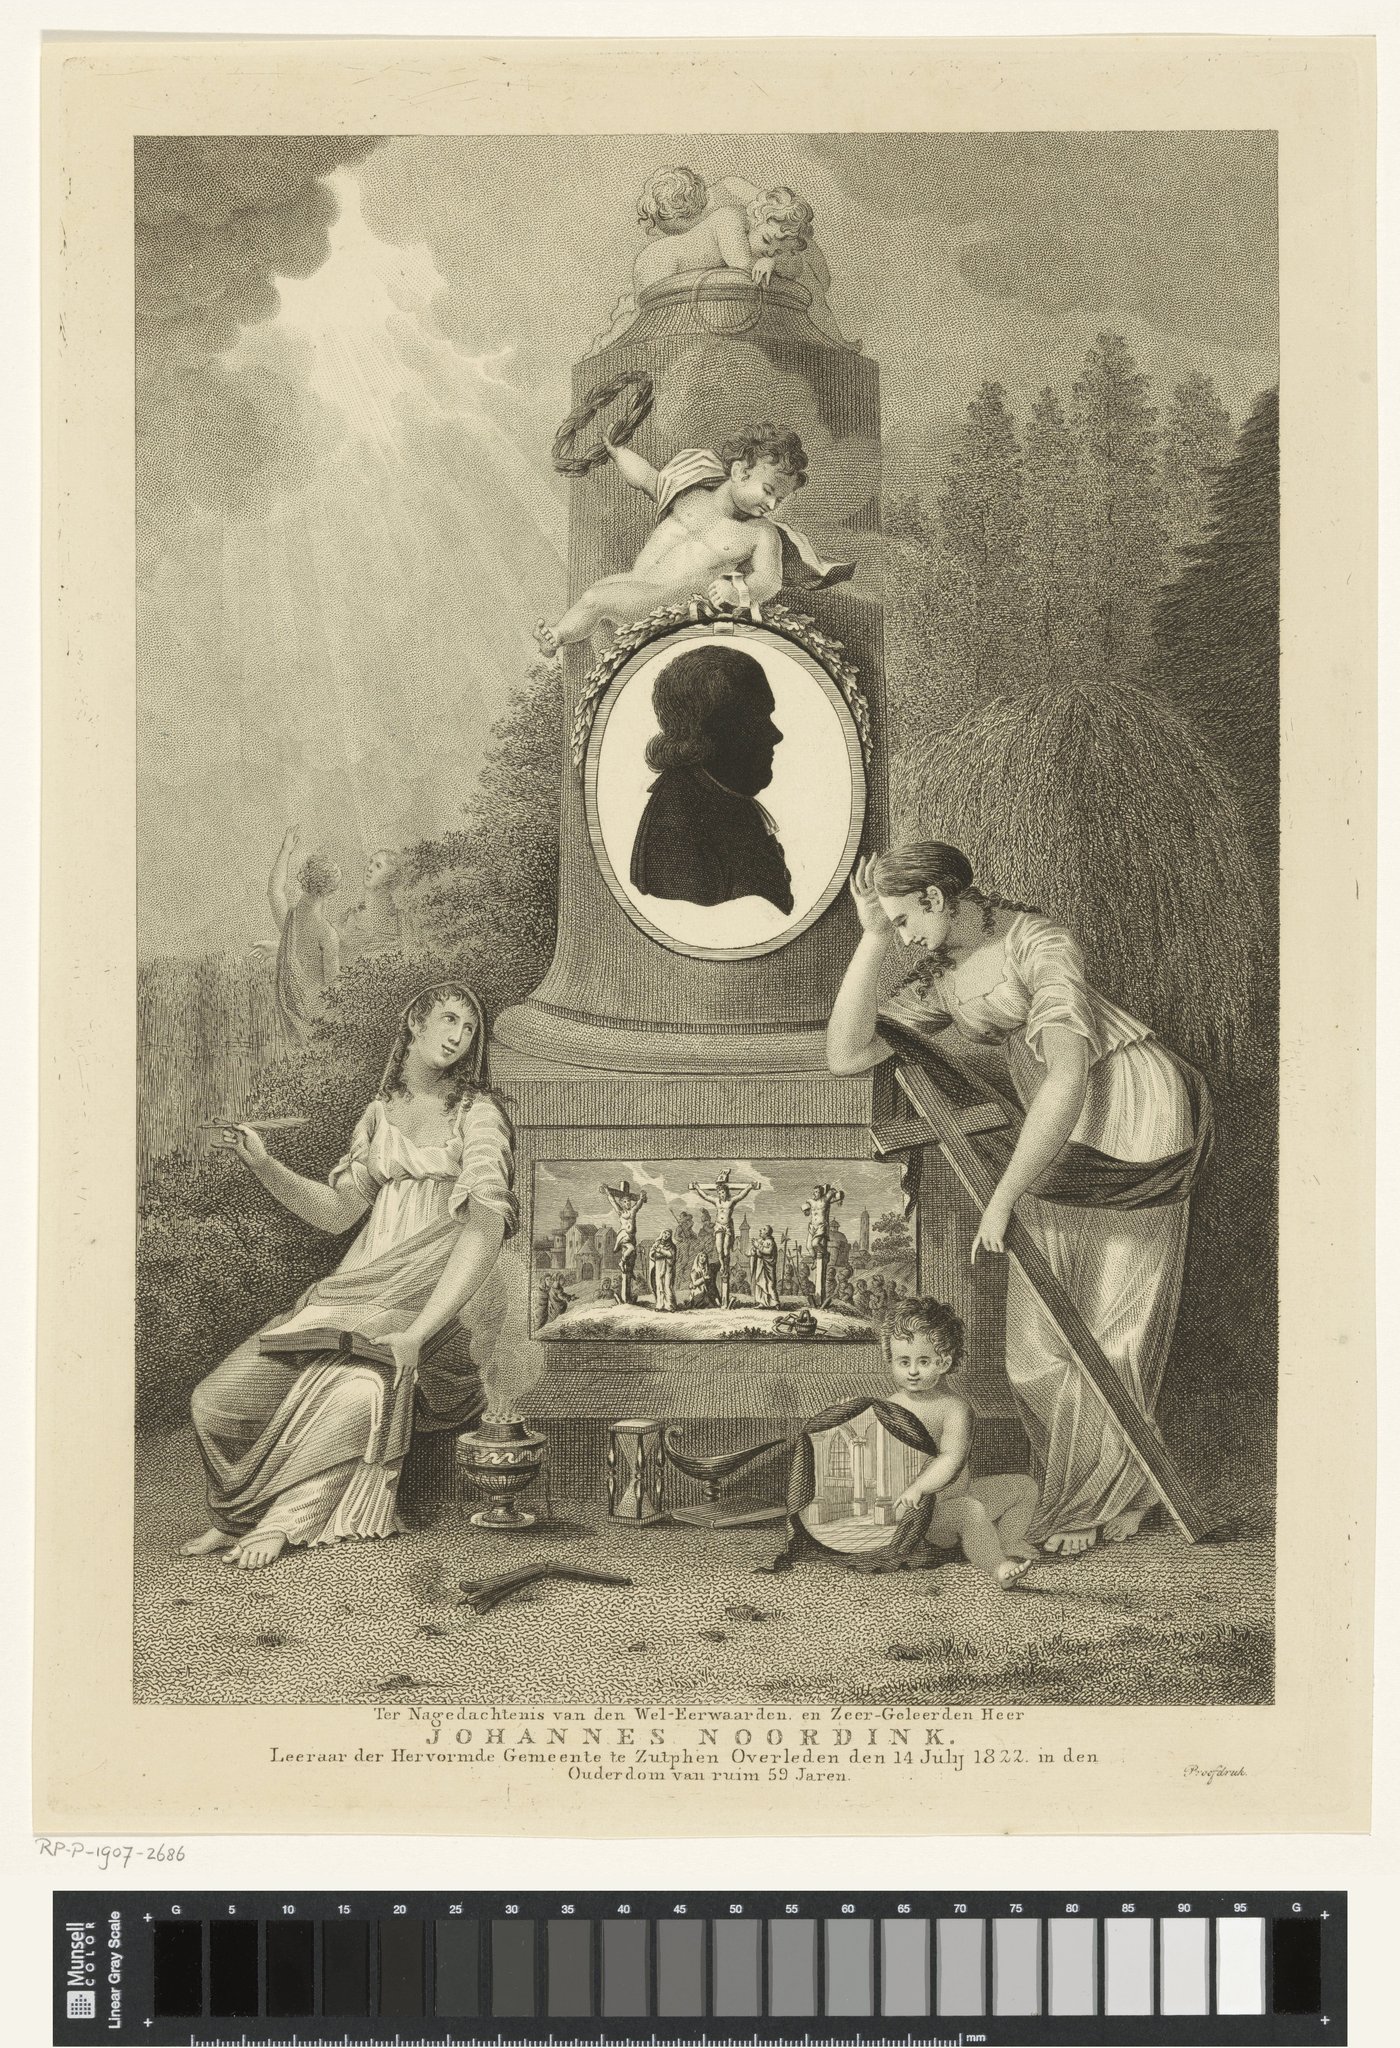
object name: print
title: Monument voor Johannes Noordink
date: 1822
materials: paper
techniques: engraving, etching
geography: amsterdam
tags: symbols of last judgement, torch (+ extinguishing; extinguished light, lamp, candle), faith, 'fides'; 'fede', 'fede catholica', 'fede christiana', 'fede christiana catholica' (ripa) ~ one of the three theological virtues, the sower ~ parable of christ (matthew 13:3-9; mark 4:3-9; luke 8:5-8), hourglass, mourning the dead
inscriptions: collector's mark: Lugt 2228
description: Monument voor de Zutphense predikant Johannes Noordink, met daarop diens silhouetportret. Bovenop de zuil twee putti die een slang vasthouden, als symbool voor de eeuwigheid. Op de basis staat de kruisiging afgebeeld. Het monument wordt geflankeerd door het Geloof met een bijbel op haar schoot en in haar hand een schrijfveer en door de treurende Godsdienst. Zij wijst op een afbeelding van een kerkinterieur, vastgehouden door een putto. Op de grond een gedoofde toorts en lamp en een zandloper ten teken van de dood. Links op de achtergrond staan twee figuren tussen korenschoven, waarvan één omhoog wijst naar het zonlicht, de ander naar het graan: Noordink zal oogsten in de hemel wat hij op aarde gezaaid heeft. Een onderschrift vermeldt de sterfdatum en functie van Noordink. Met bijbehorend tekstblad met uitleg.